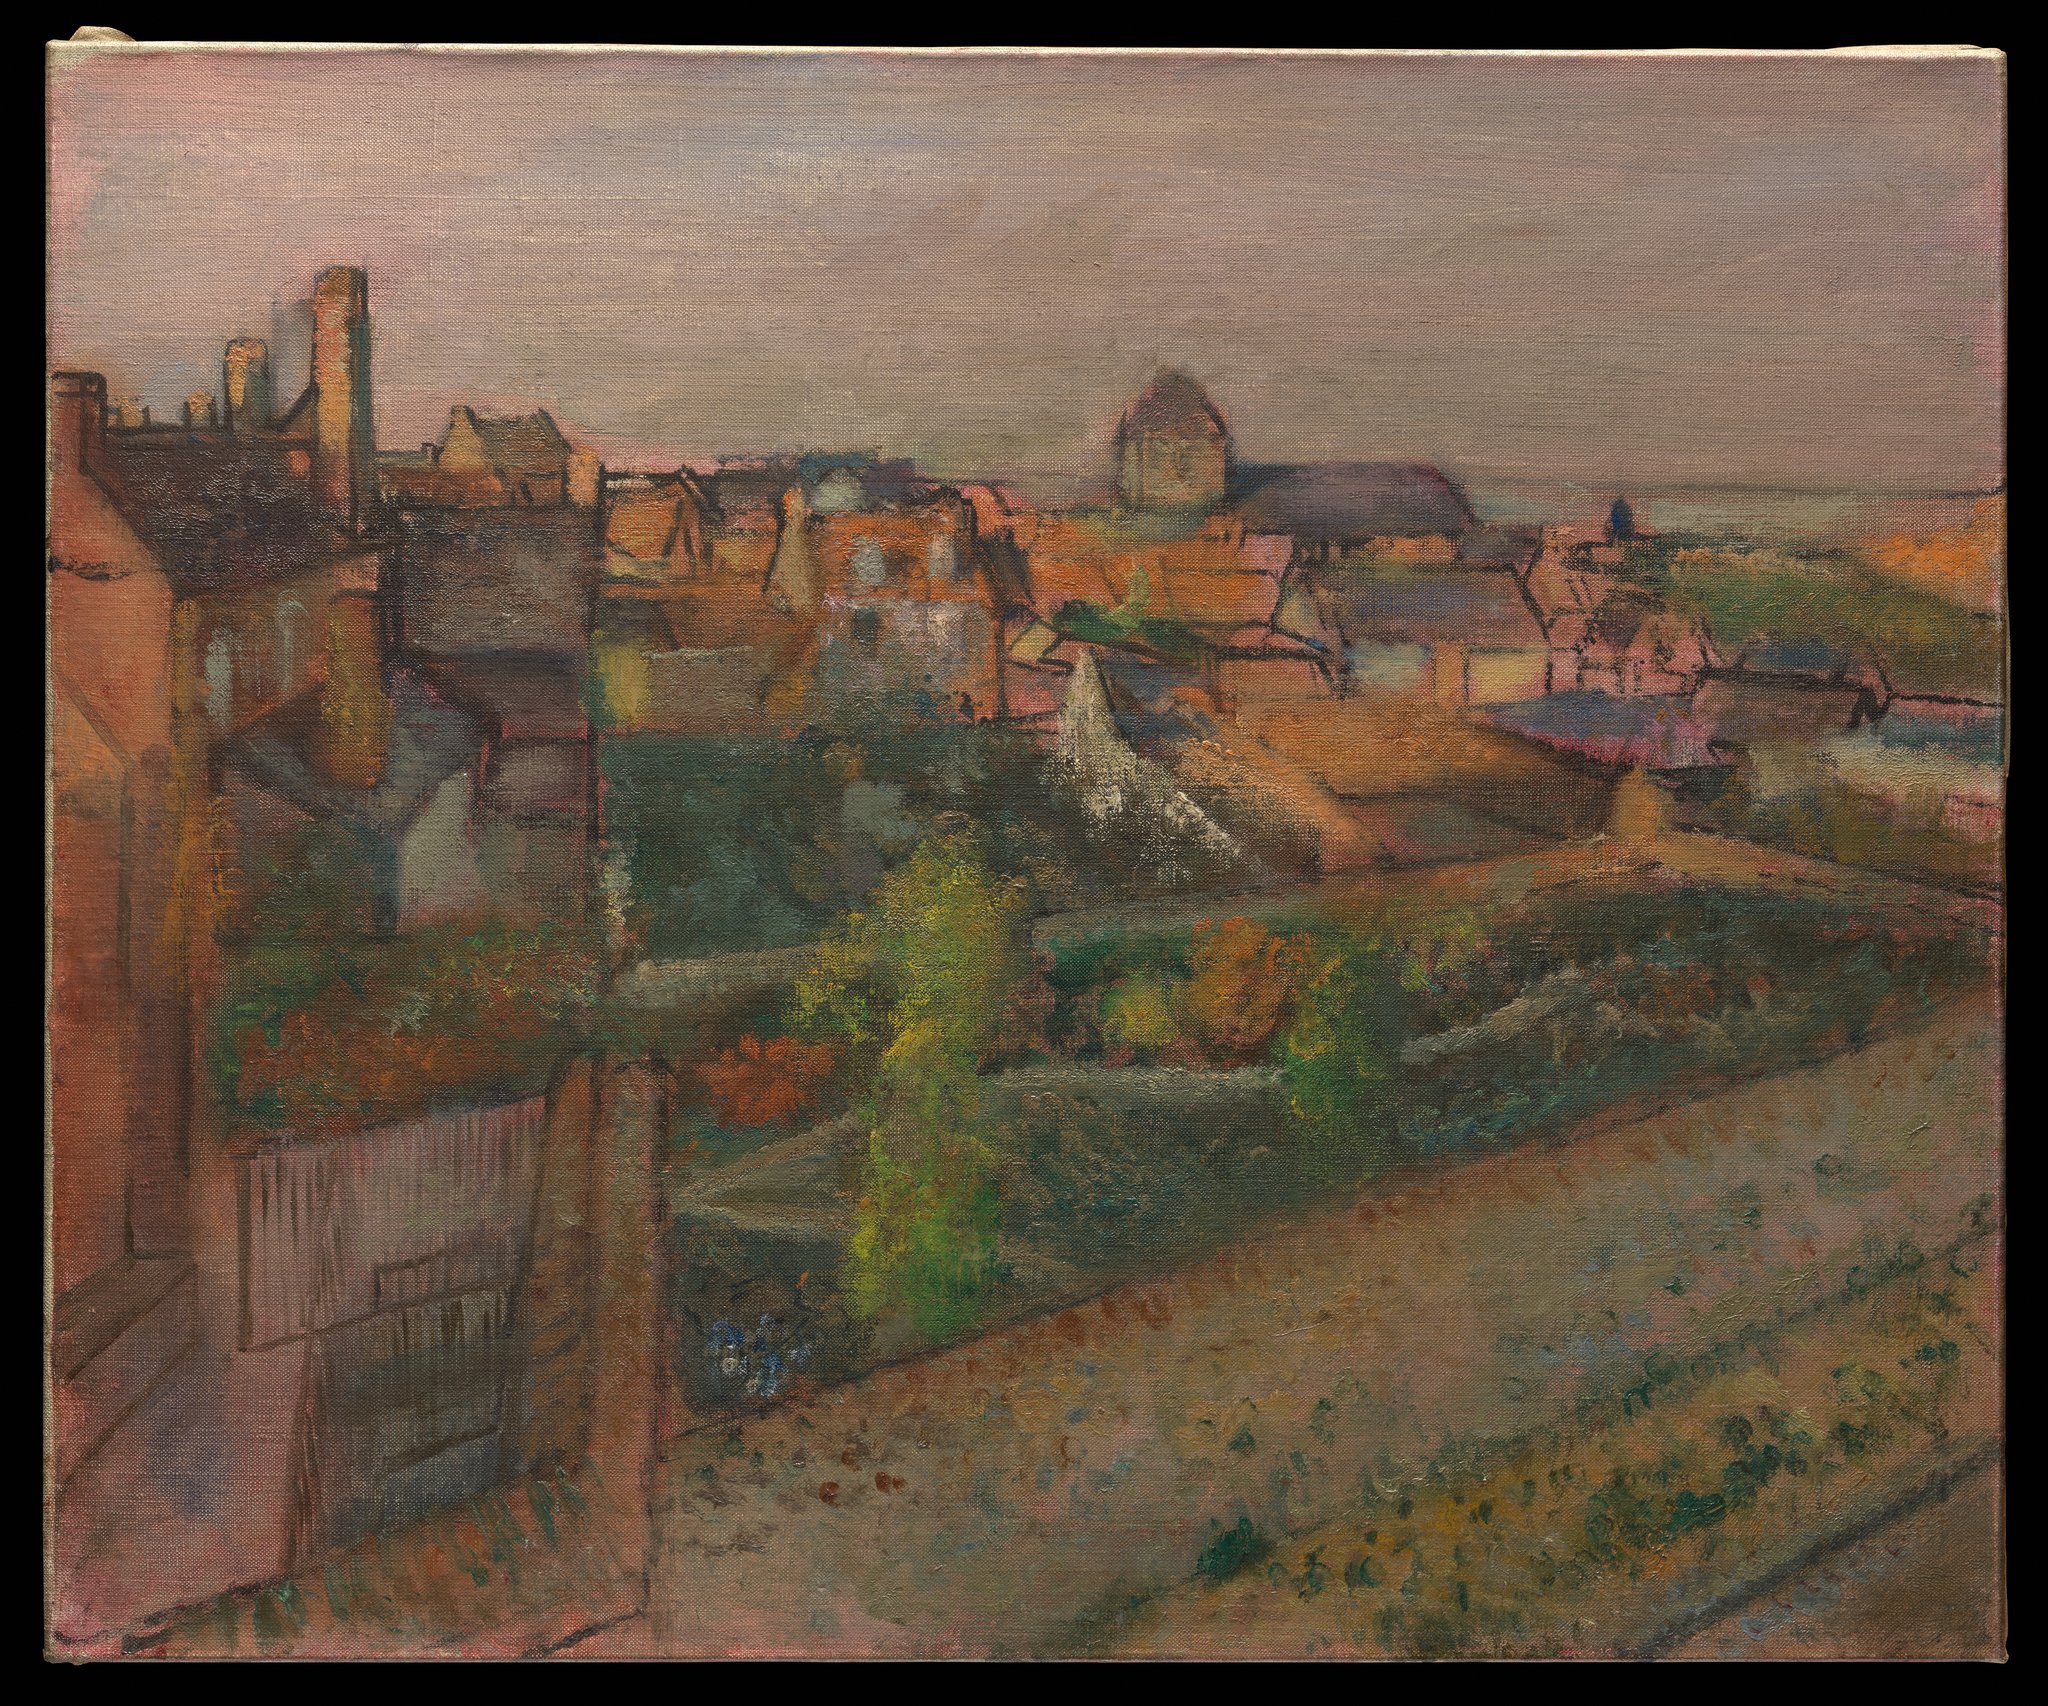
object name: painting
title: View of Saint-Valéry-sur-Somme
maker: edgar degas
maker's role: artist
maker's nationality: french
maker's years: 1834-1917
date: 1896-1898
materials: canvas, oil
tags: towns,landscapes